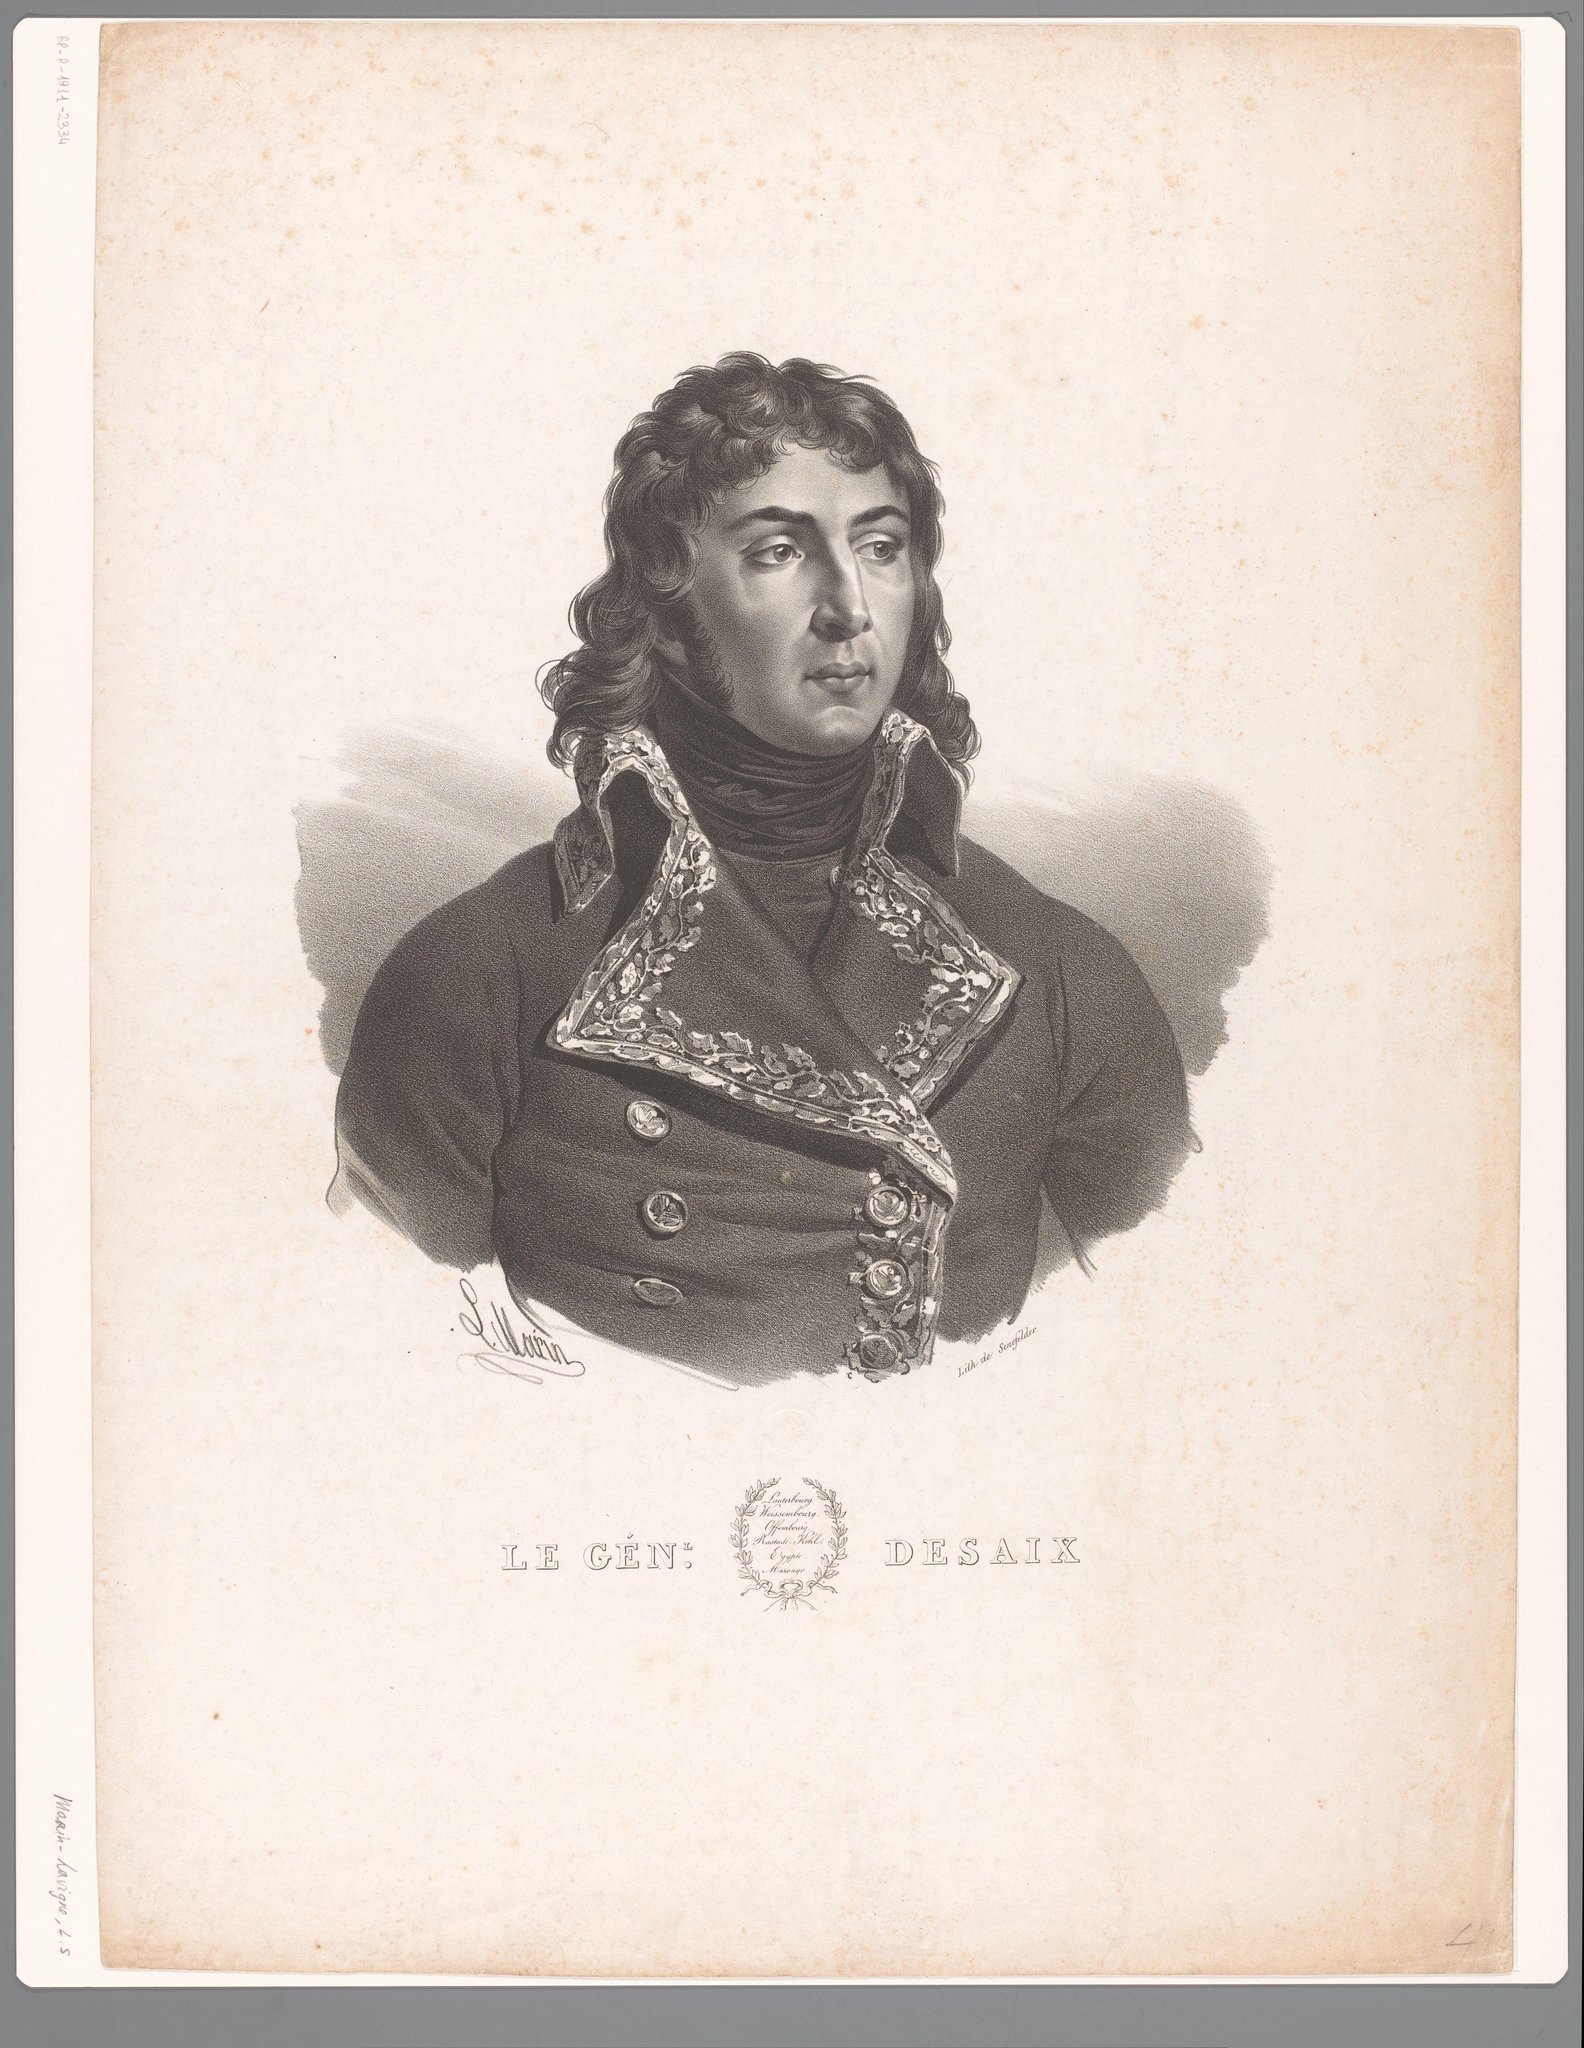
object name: print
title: Portret van generaal Louis Charles Antoine Desaix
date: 1821-1833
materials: paper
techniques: lithograph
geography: paris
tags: historical persons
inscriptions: collector's mark: Lugt 2228, check stamp: Lugt 619